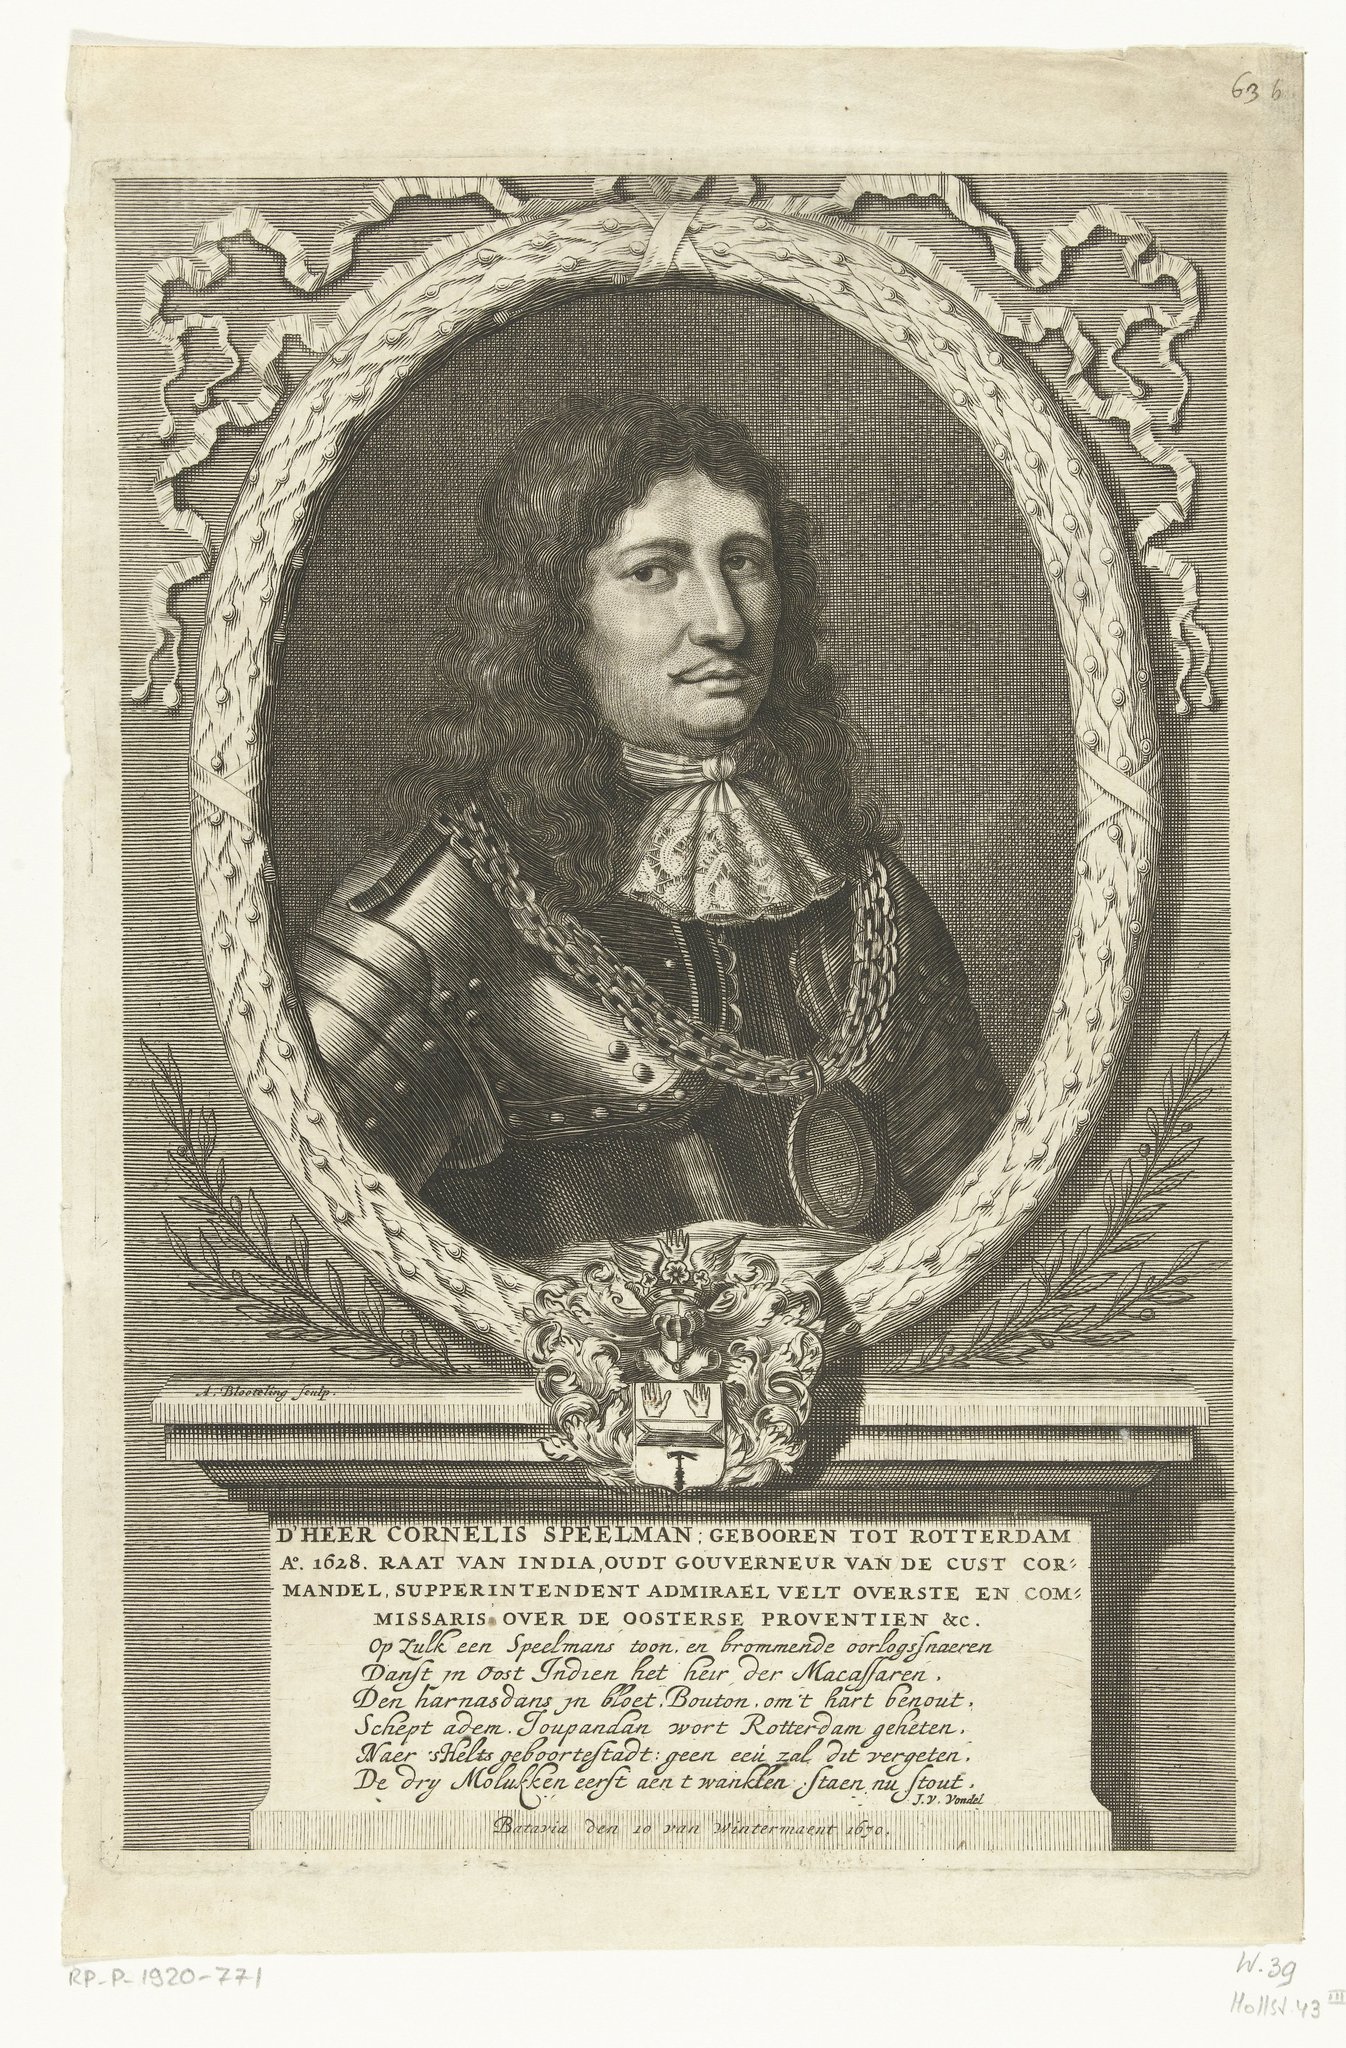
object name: print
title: Portret van Cornelis Speelman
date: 1670-1690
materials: paper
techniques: engraving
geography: amsterdam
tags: batavia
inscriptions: number: ‘636’, collector's mark: Lugt 2228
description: Borstbeeld van Cornelis Jansz. Speelman, gouverneur-generaal van de VOC. Speelman draagt de ketting met gouden medaille die hij heeft ontvangen voor de succesvolle onderwerping van de provincie Makassar op het eiland Celebes. Onder het portret een vers over de benoeming van een fort op Celebes naar de stad Rotterdam, de geboorteplaats van Speelman.